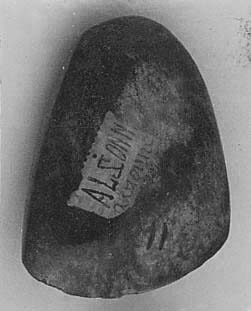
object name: knife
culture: french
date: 1902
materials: jade